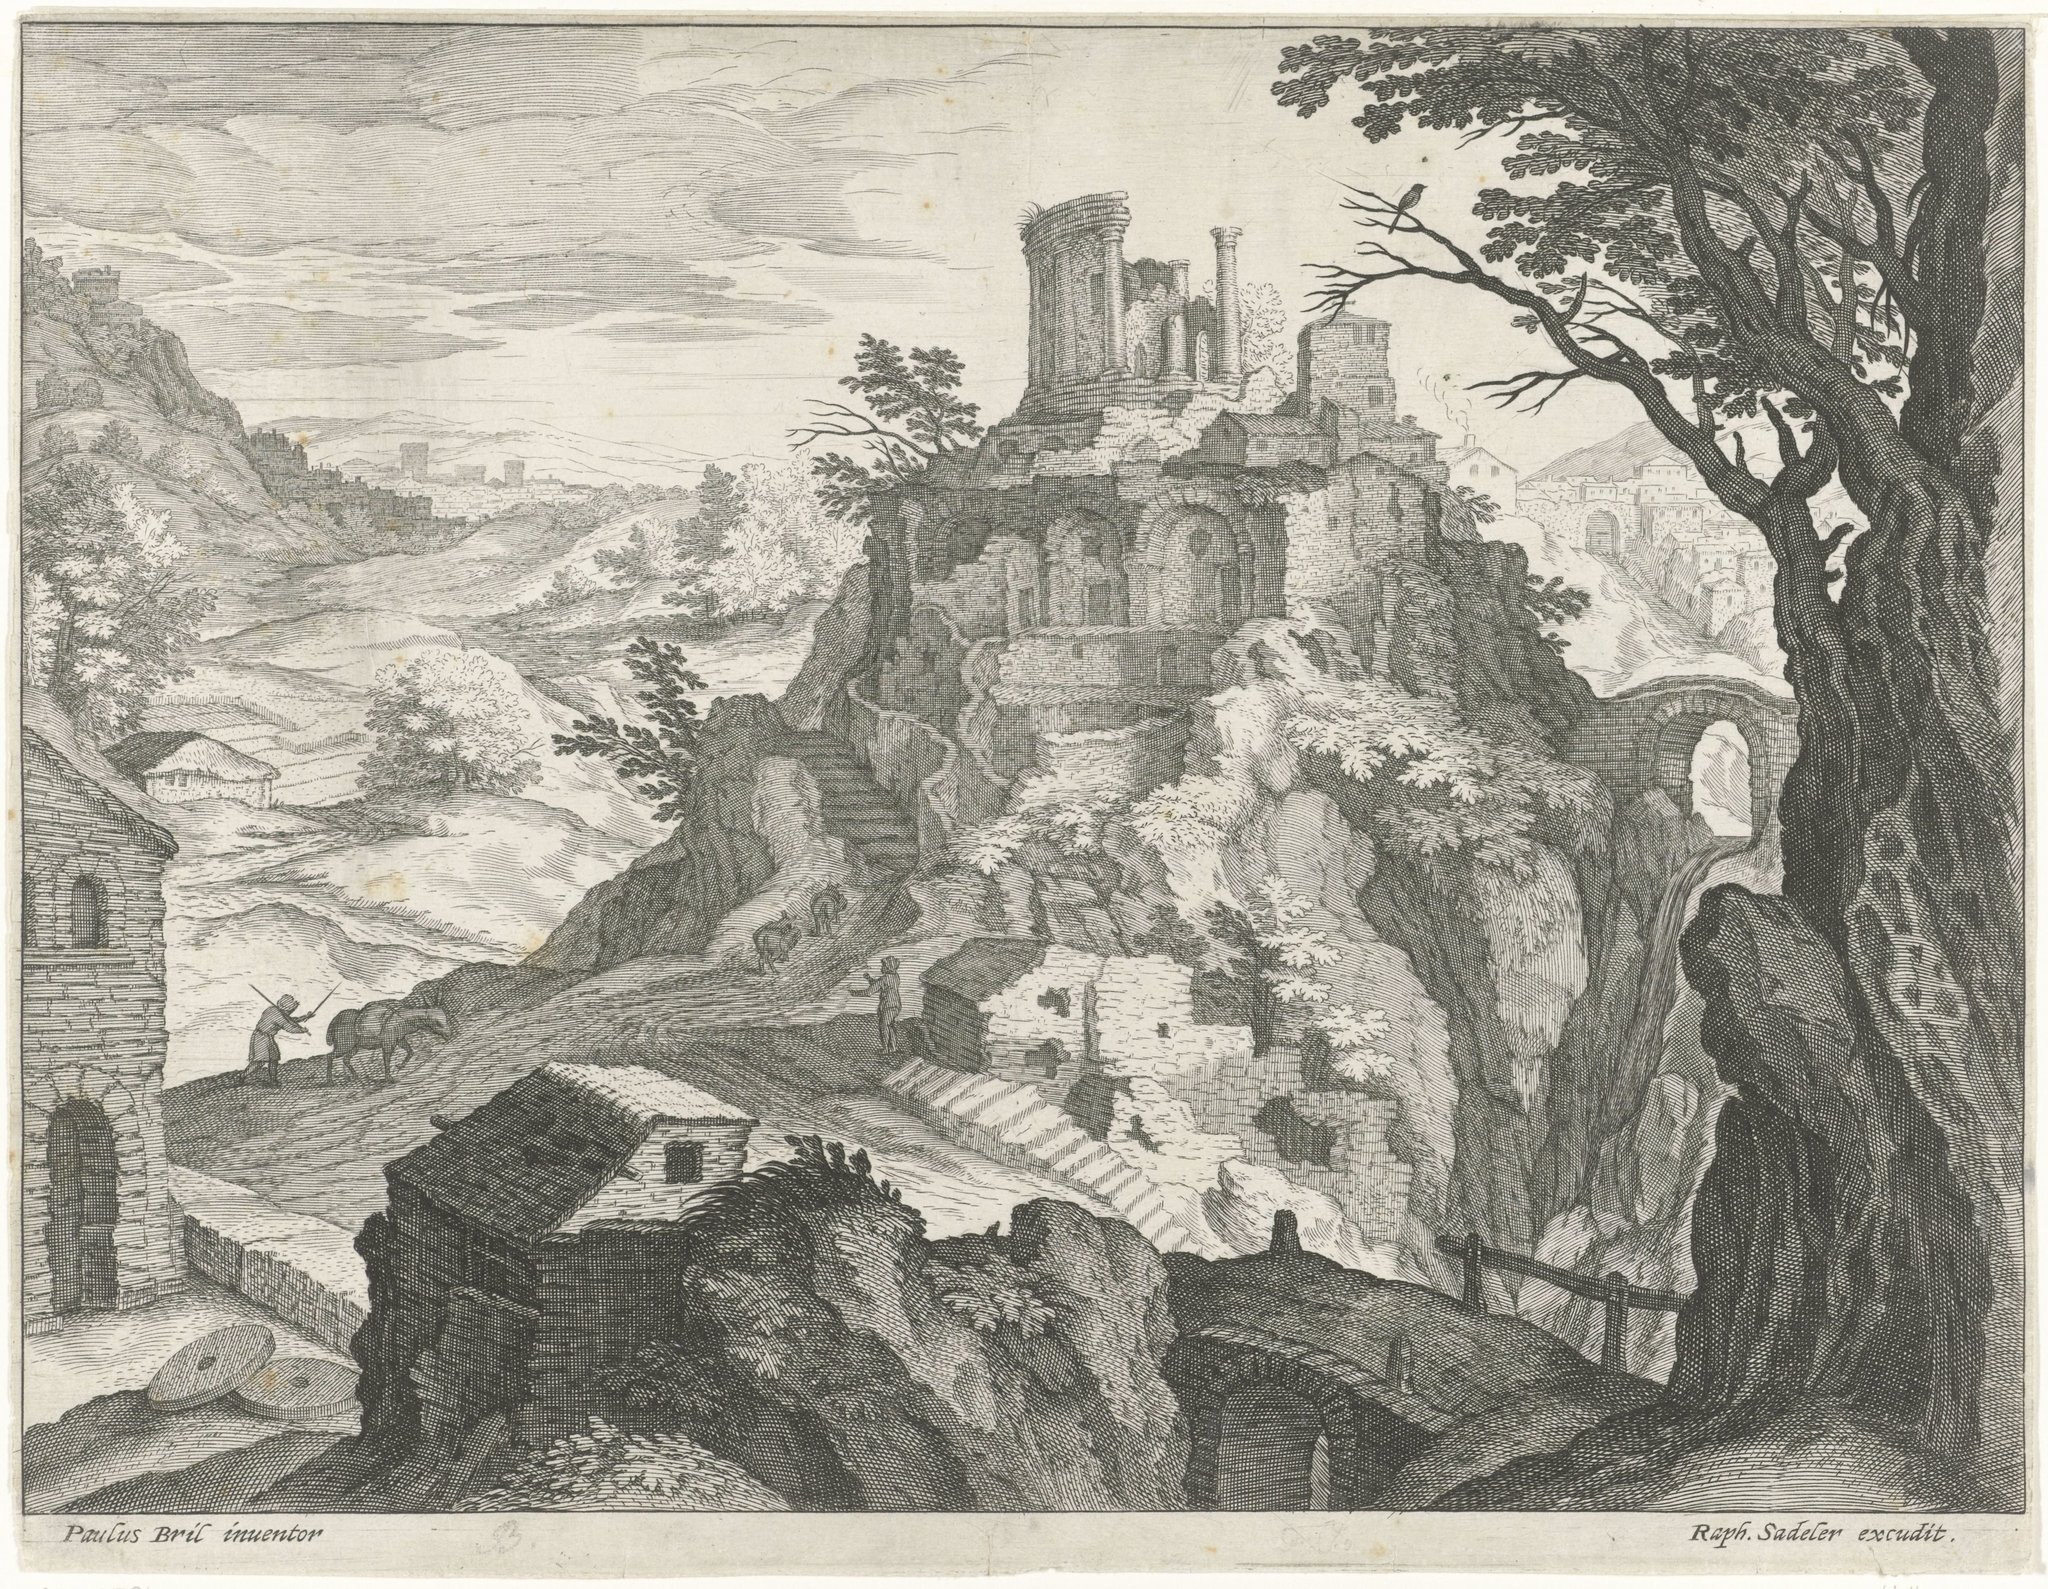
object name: print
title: Landschap met de tempel van Vesta te Tivoli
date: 1570-1632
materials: paper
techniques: engraving, etching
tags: low hill country, 'en route', traveller under way, landscape with ruins (+ city(-scape) with figures, staffage)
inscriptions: collector's mark: Lugt 240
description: Landschap met op een berg de tempel van Vesta in Tivoli. Op de voorgrond een man en zijn ezel.